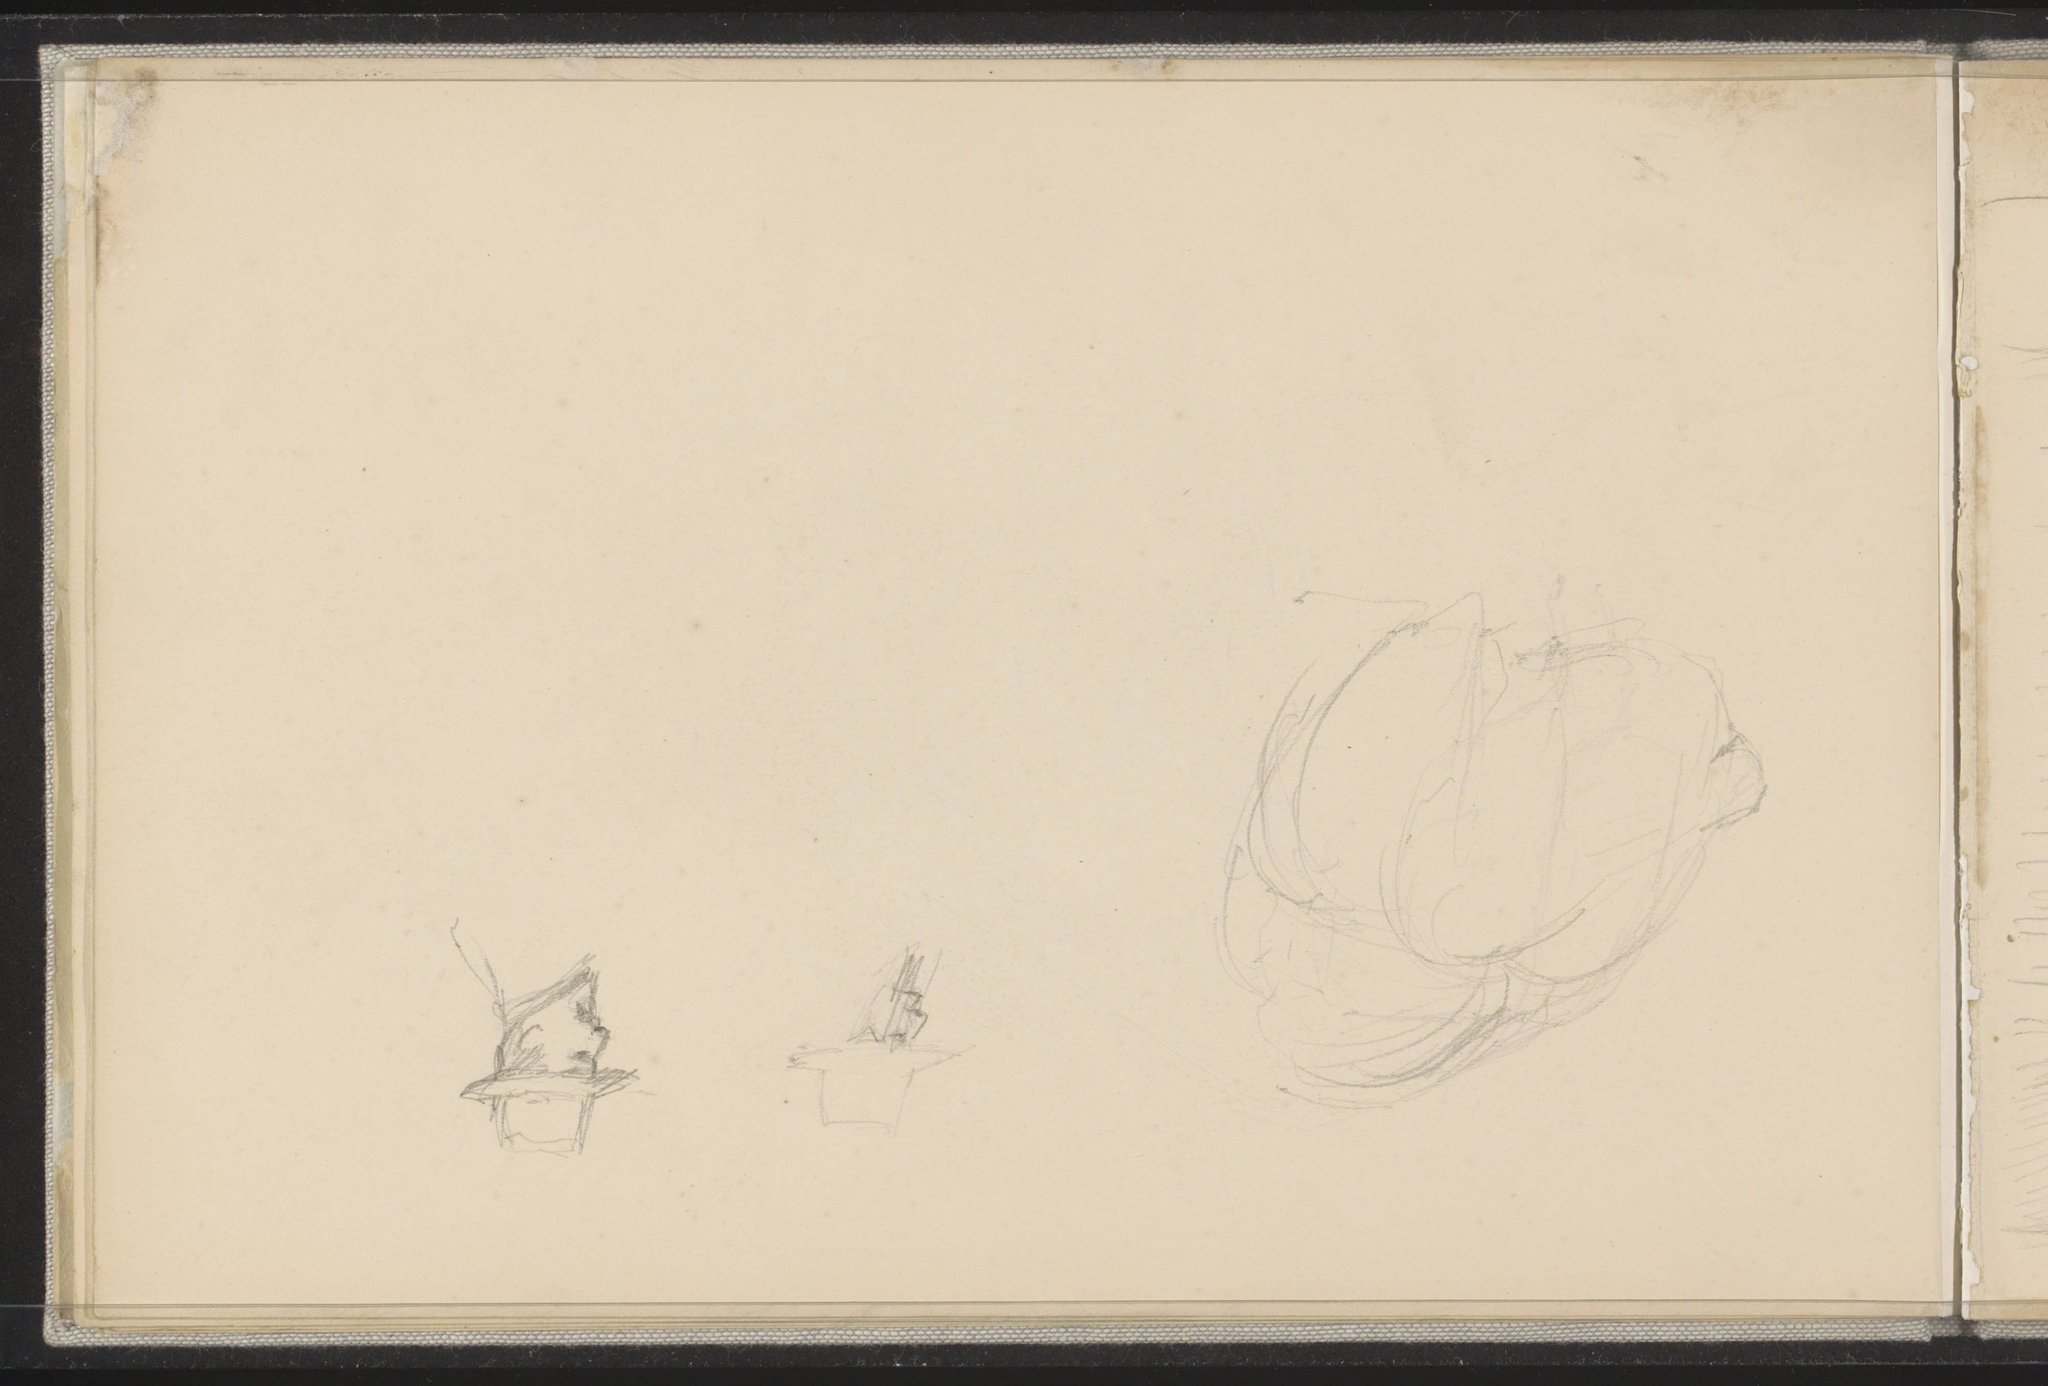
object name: sketchbook leaf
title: Kop van een man met een hoge hoed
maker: jozef israëls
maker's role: draughtsman, painter, print maker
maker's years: 1824-1911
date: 1834-1911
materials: paper, pencil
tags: head (human) (+ adult male (human being)), head-gear: top hat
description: Tevens een studie. Blad 12 verso uit een schetsboek met 30 bladen.